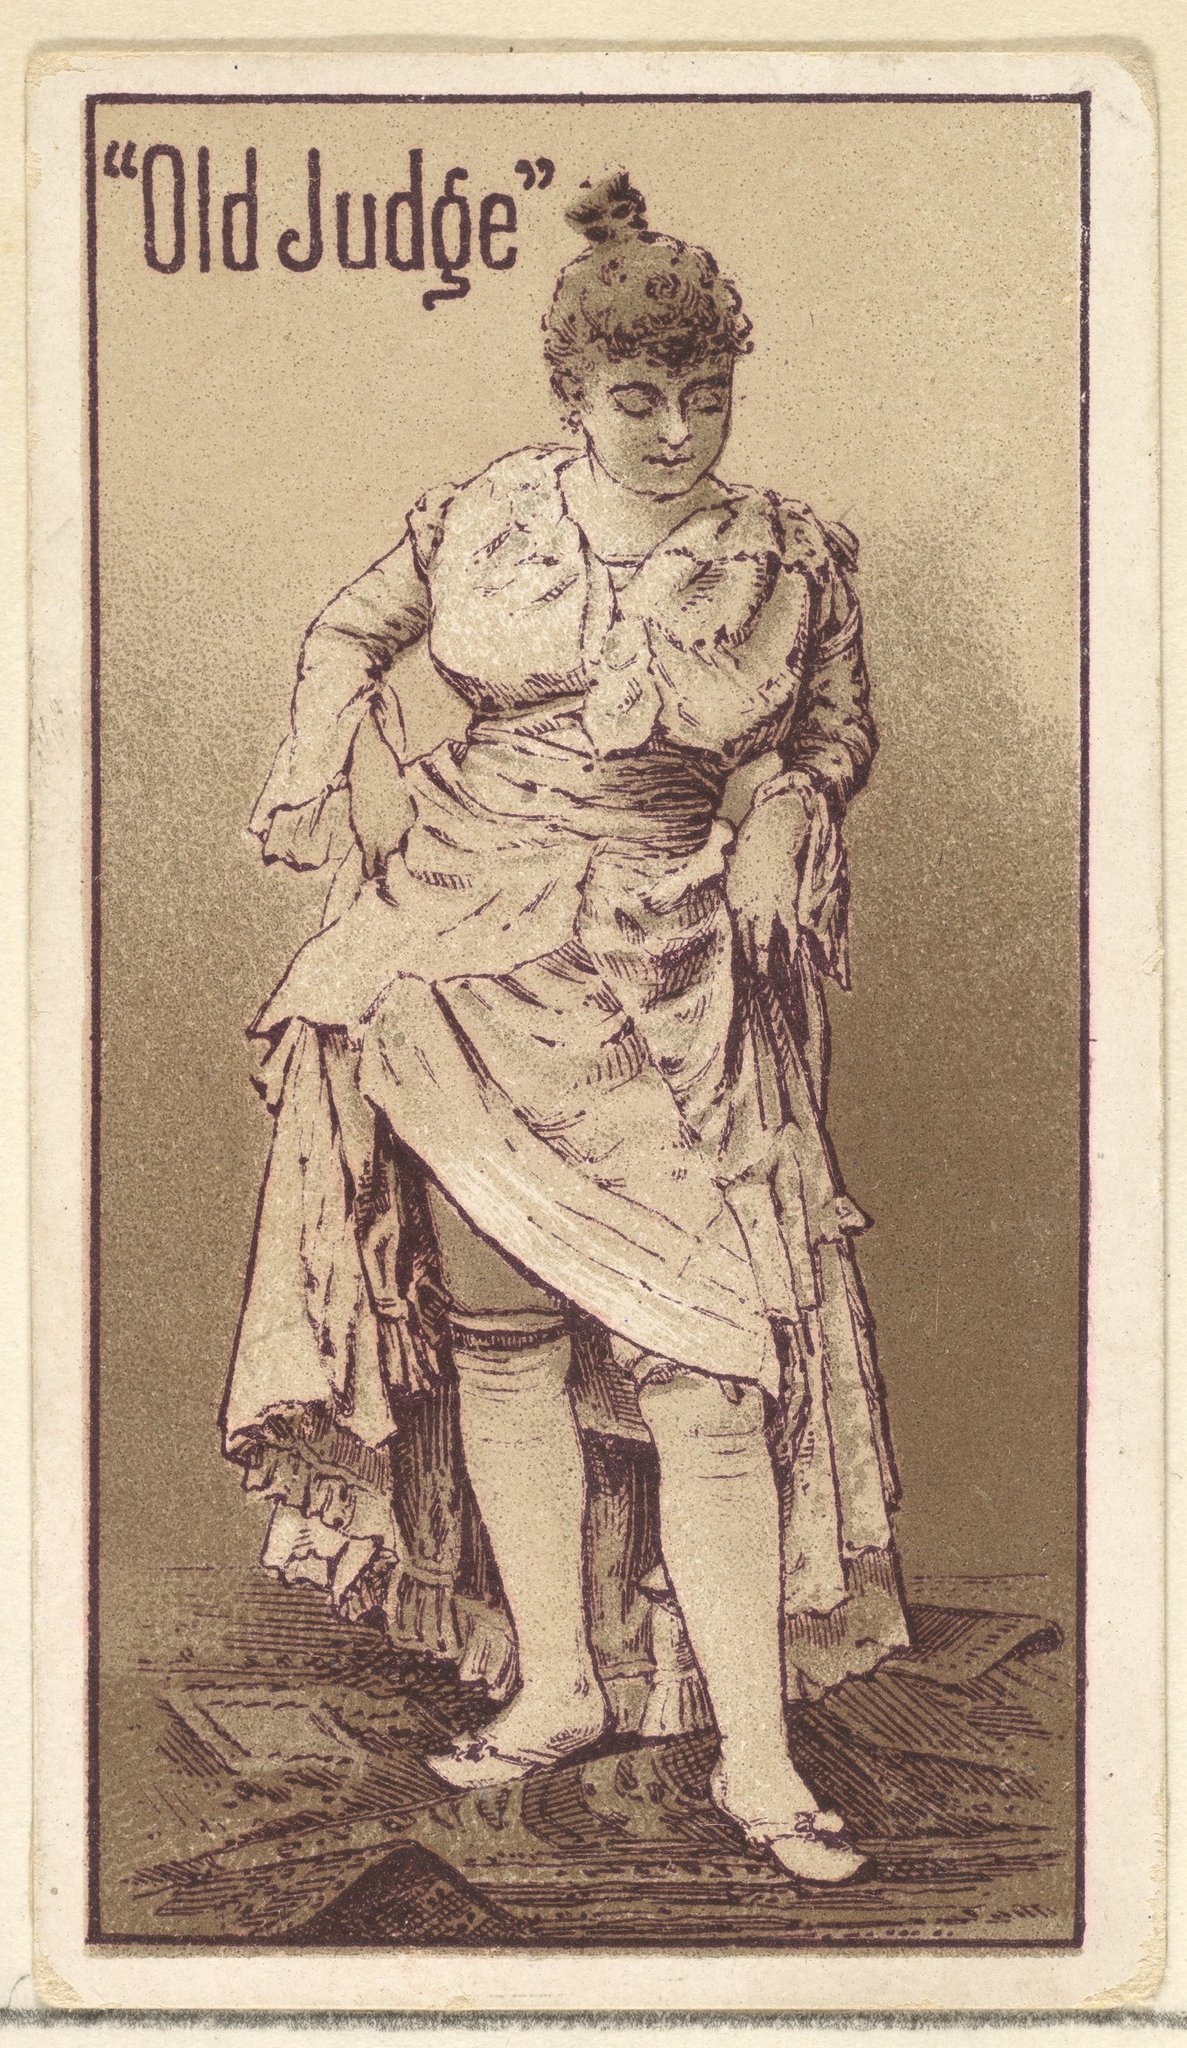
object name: print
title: Actress from the Old Judge series (N167) for Old Judge Cigarettes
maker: goodwin & company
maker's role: publisher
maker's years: 1850-1950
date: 1886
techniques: lithography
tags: portraits,women